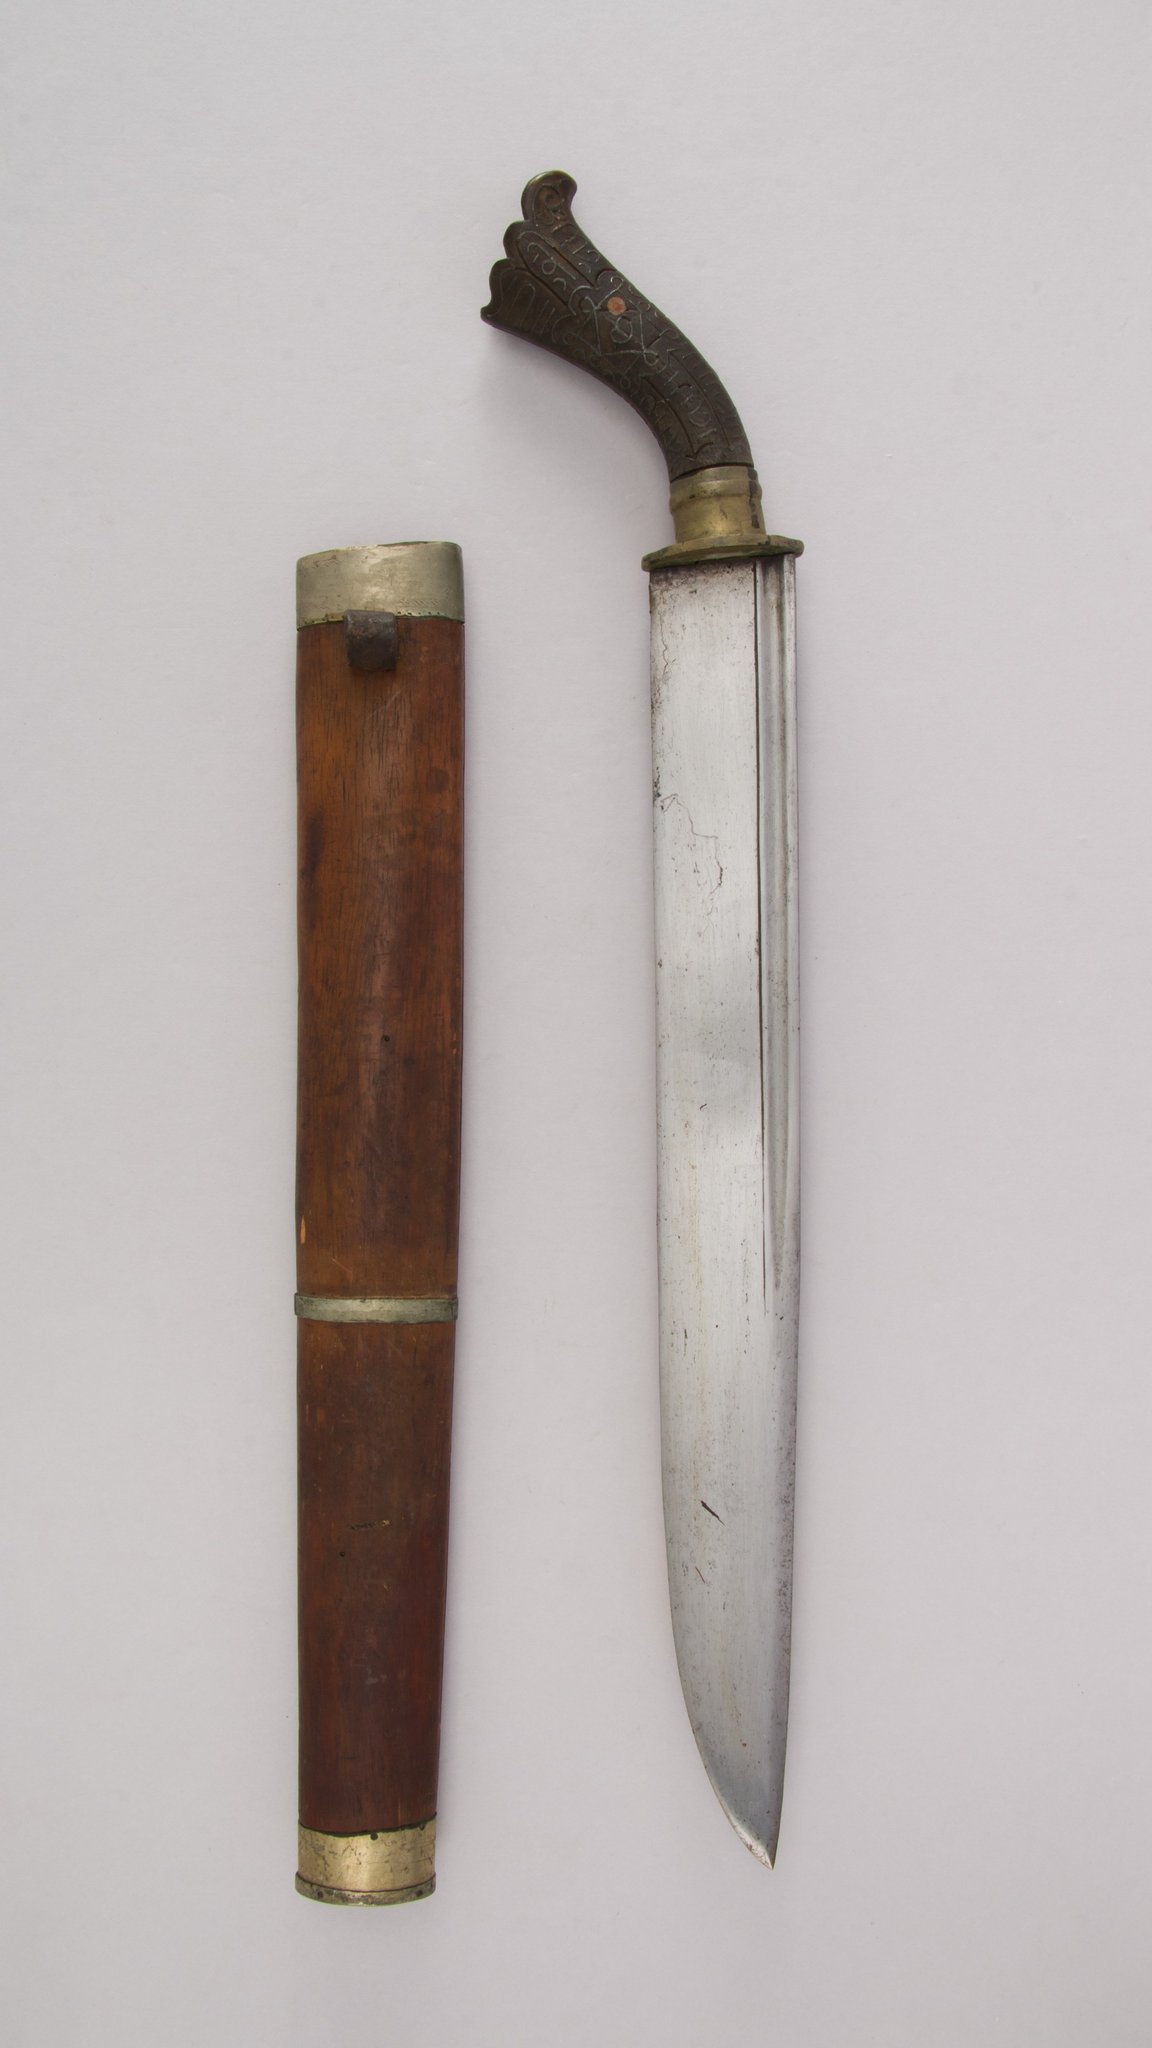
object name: knife with sheath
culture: philippine, moro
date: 1701-1900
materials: nickel, silver, steel, wood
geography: philippines